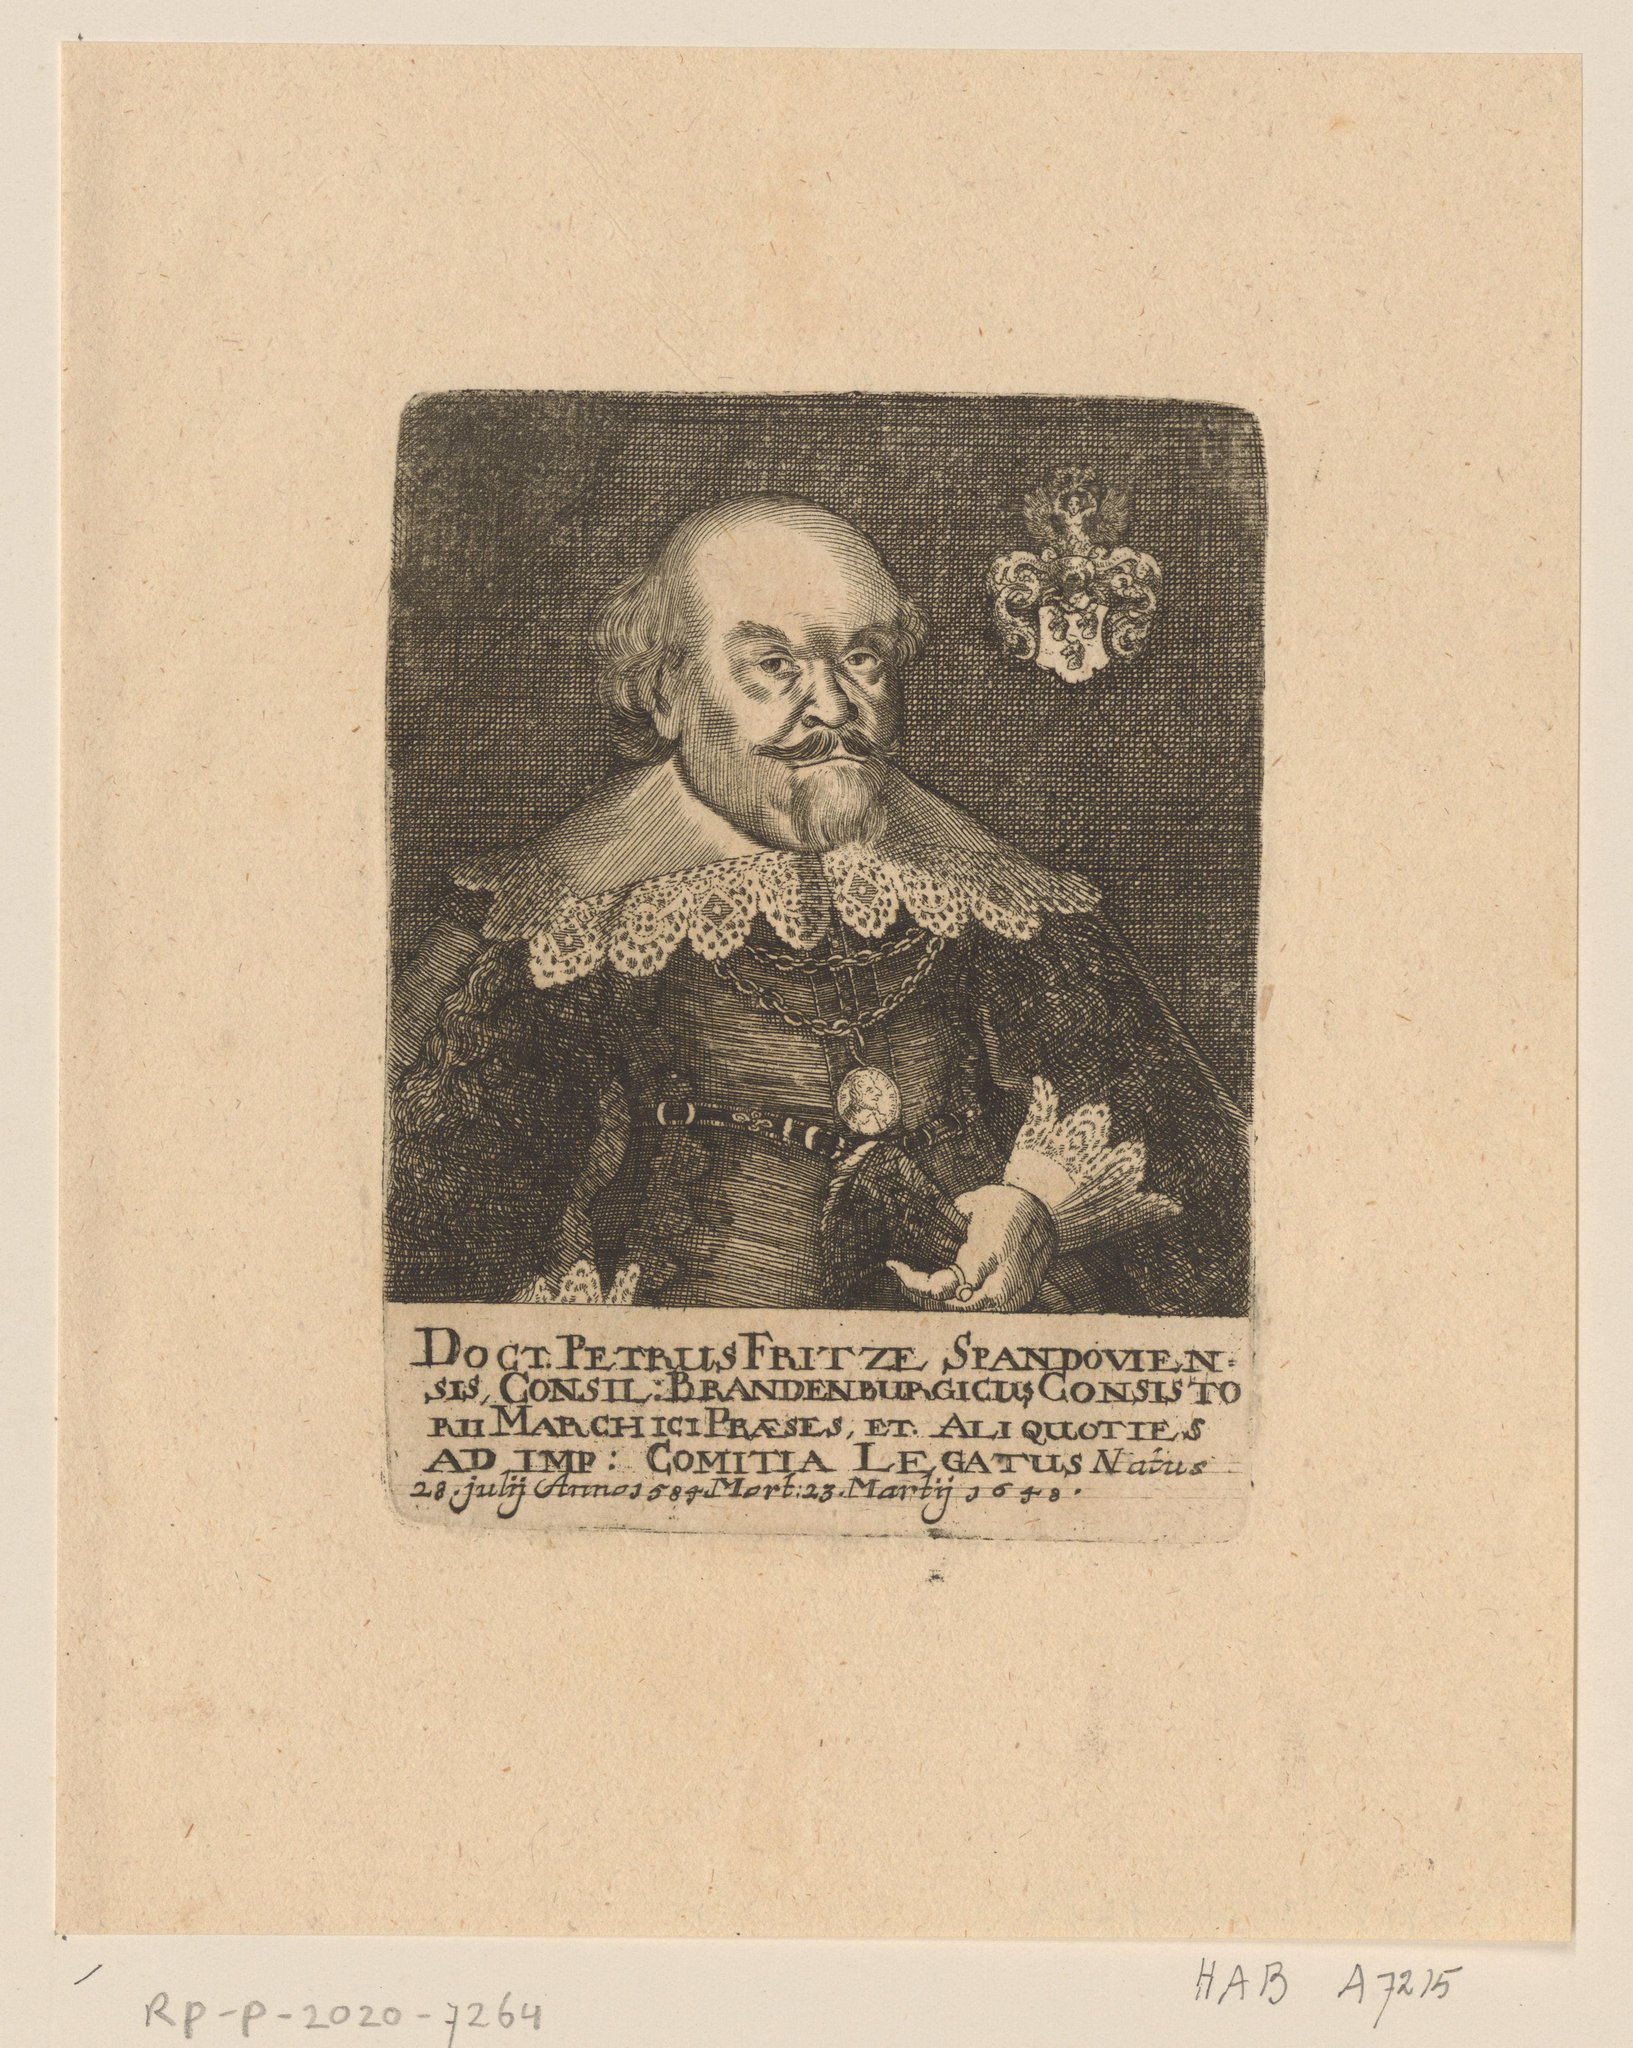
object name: print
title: Portret van Petrus Fritze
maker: Anonymous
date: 1751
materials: paper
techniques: engraving, etching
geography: germany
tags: historical persons, armorial bearing, heraldry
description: Prent waarschijnlijk uit: Küster, Georg Gottfried. Martin Friedrich Seidels Bilder-Sammlung in welcher hundert, gröstentheils in der Mark Brandenburg (…). Berlijn: Buchladen bey der Real-Schule, 1751.